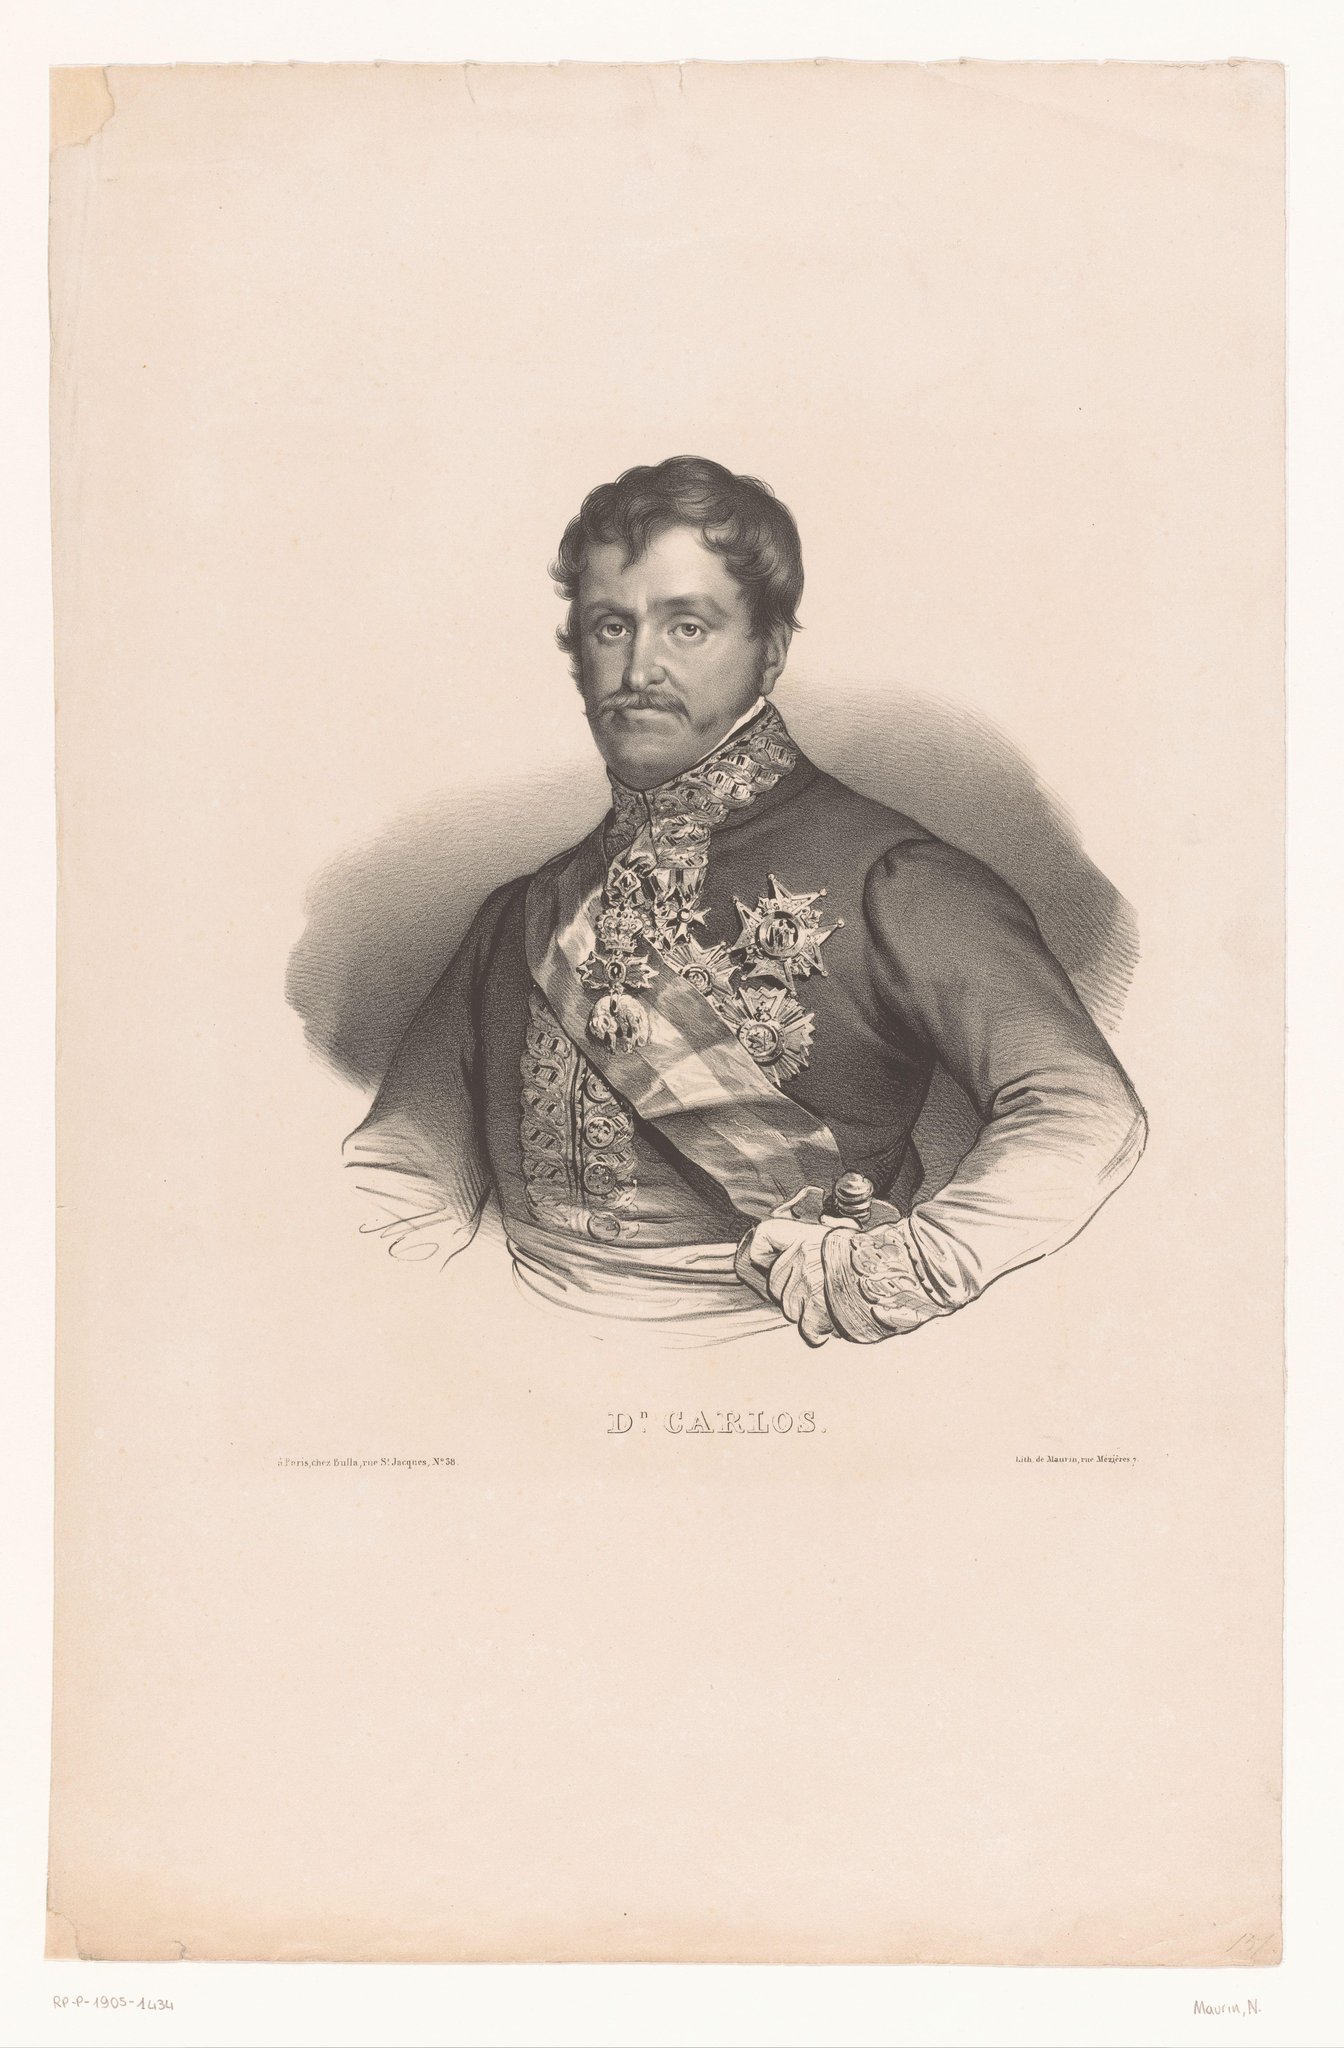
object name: print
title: Dn. Carlos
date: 1833-1850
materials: paper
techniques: lithograph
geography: paris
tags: historical persons, politician, e.g. party leader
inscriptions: collector's mark: Lugt 2228